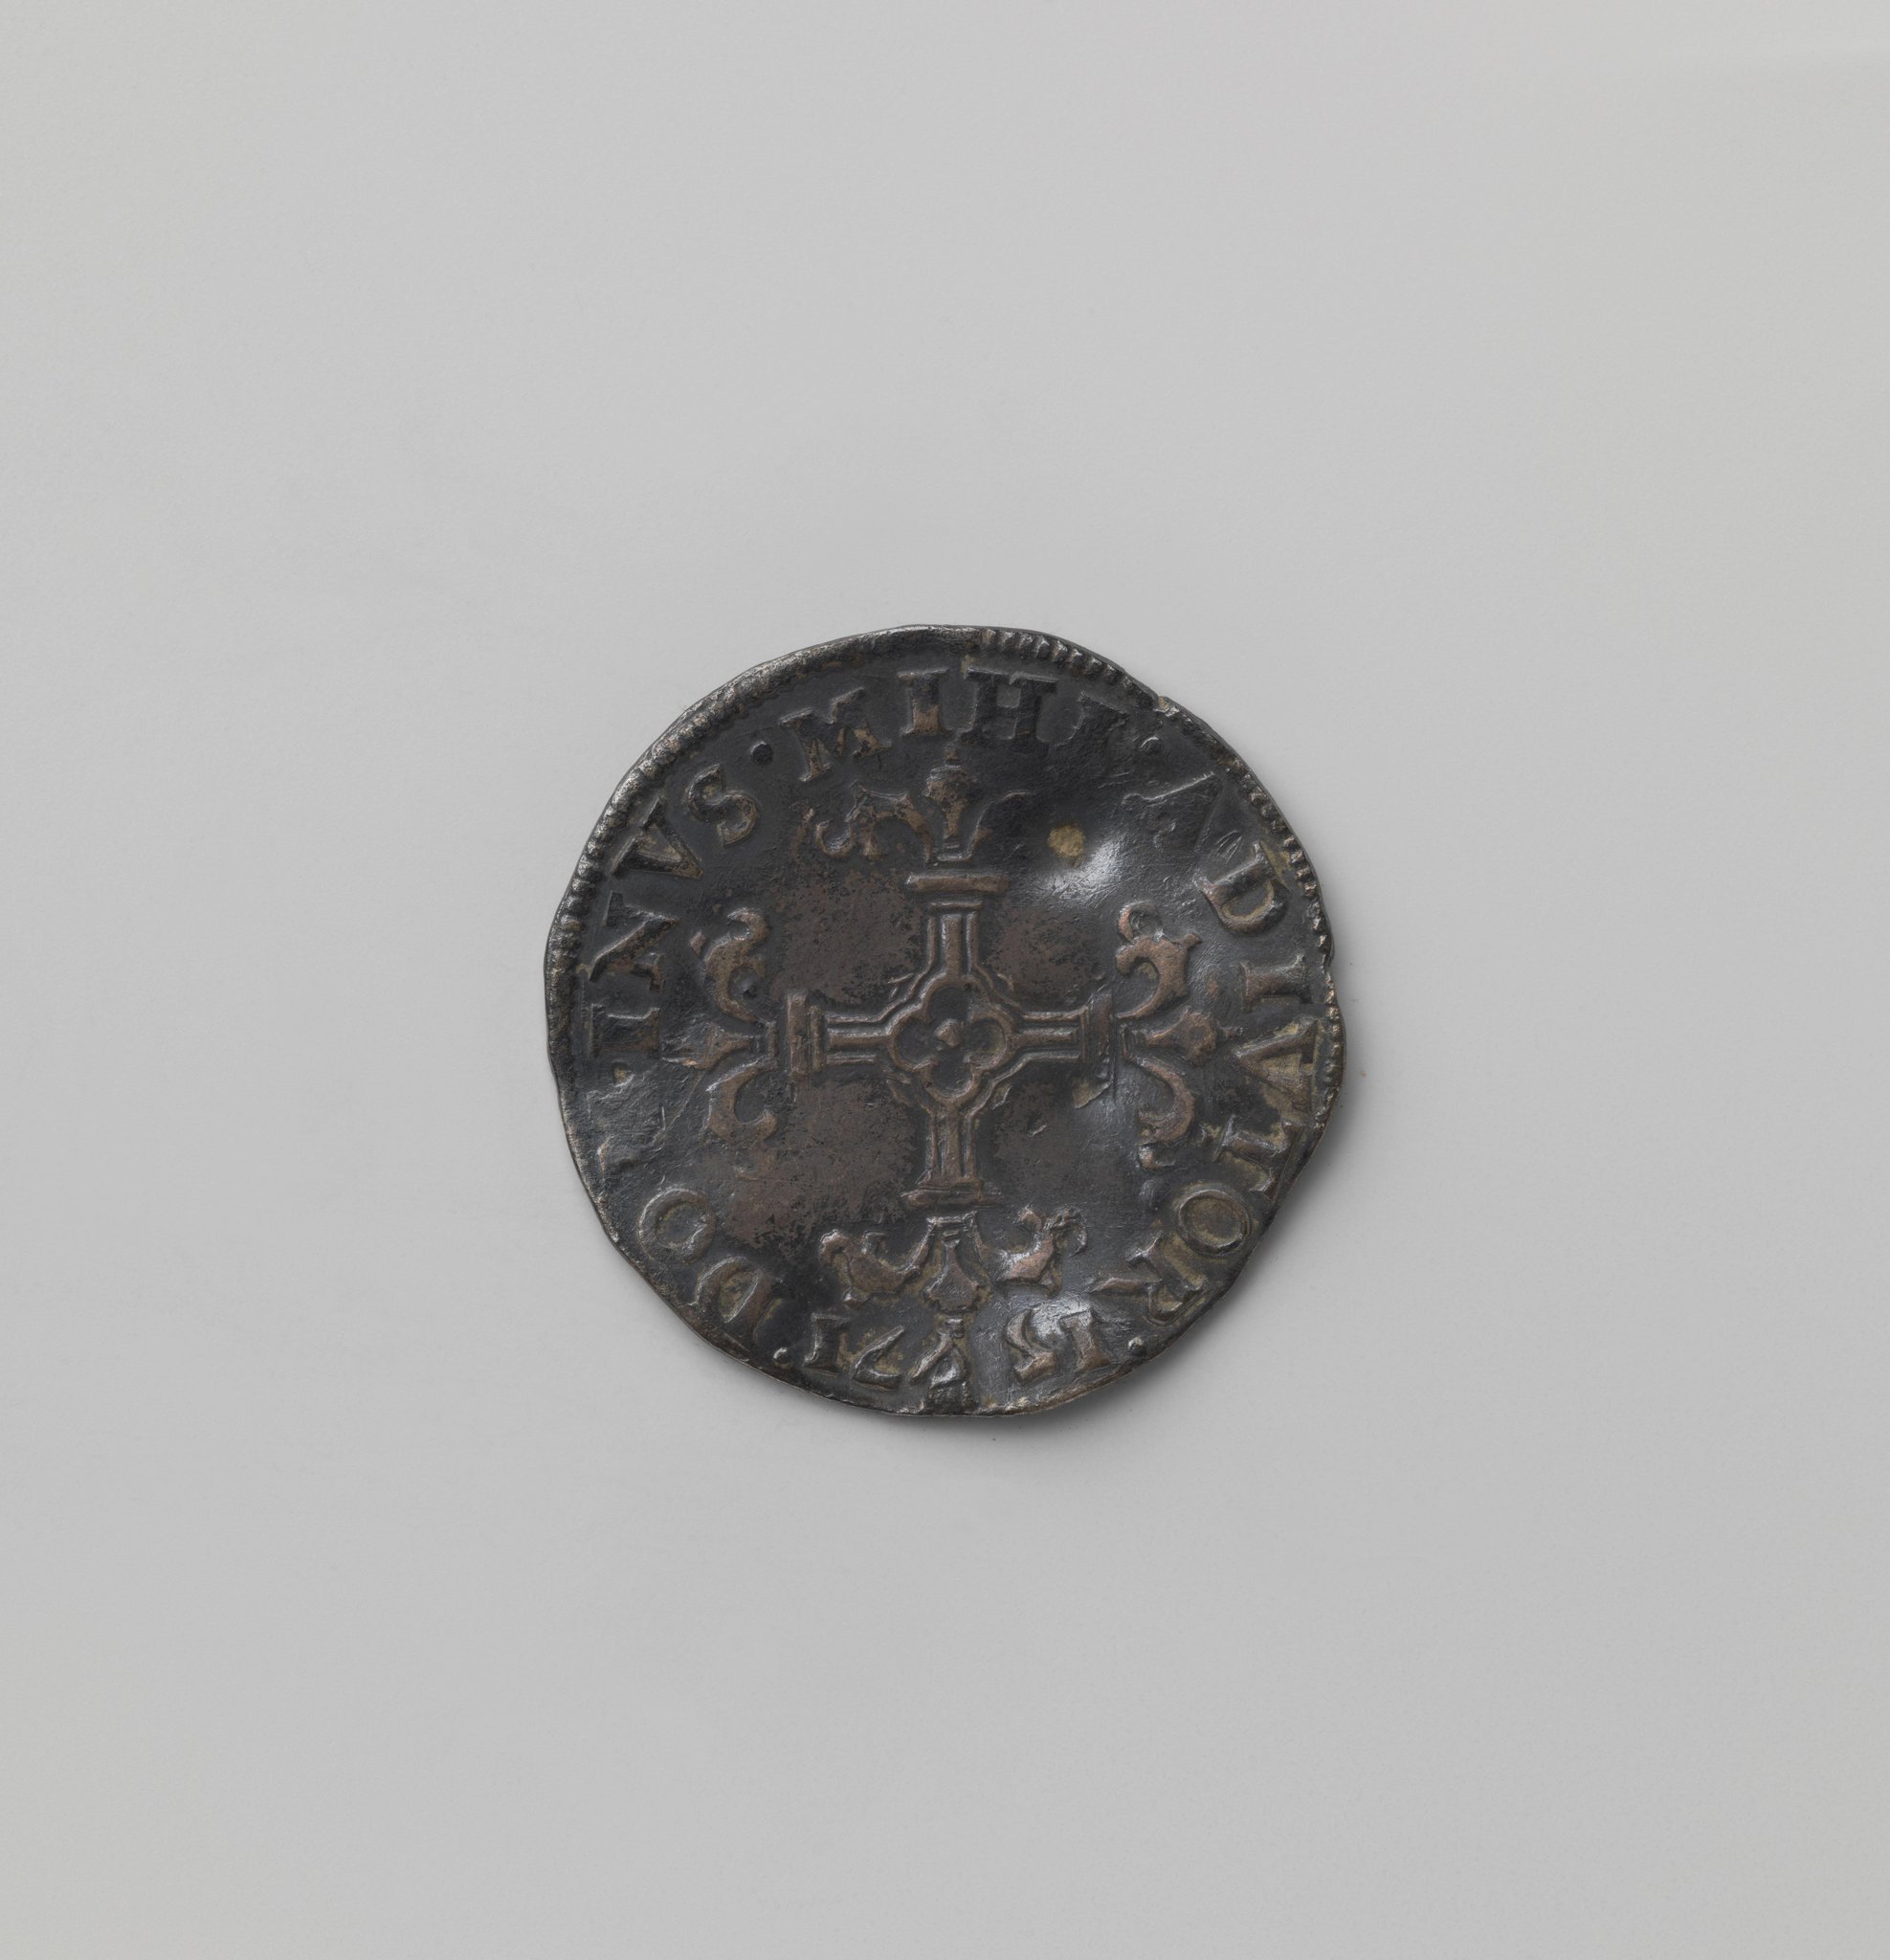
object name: coin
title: Twintigste philipsdaalder uit Brabant van Philips II, 1571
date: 1571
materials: silver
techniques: striking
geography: antwerp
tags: philip ii of spain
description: Zilveren munt. Voorzijde: met de orde van het gulden vlies omhangen gekroond wapenschild. Keerzijde: kort gebloemd kruis. Jaartal, waartussen hand, in omschrift bovenaan.